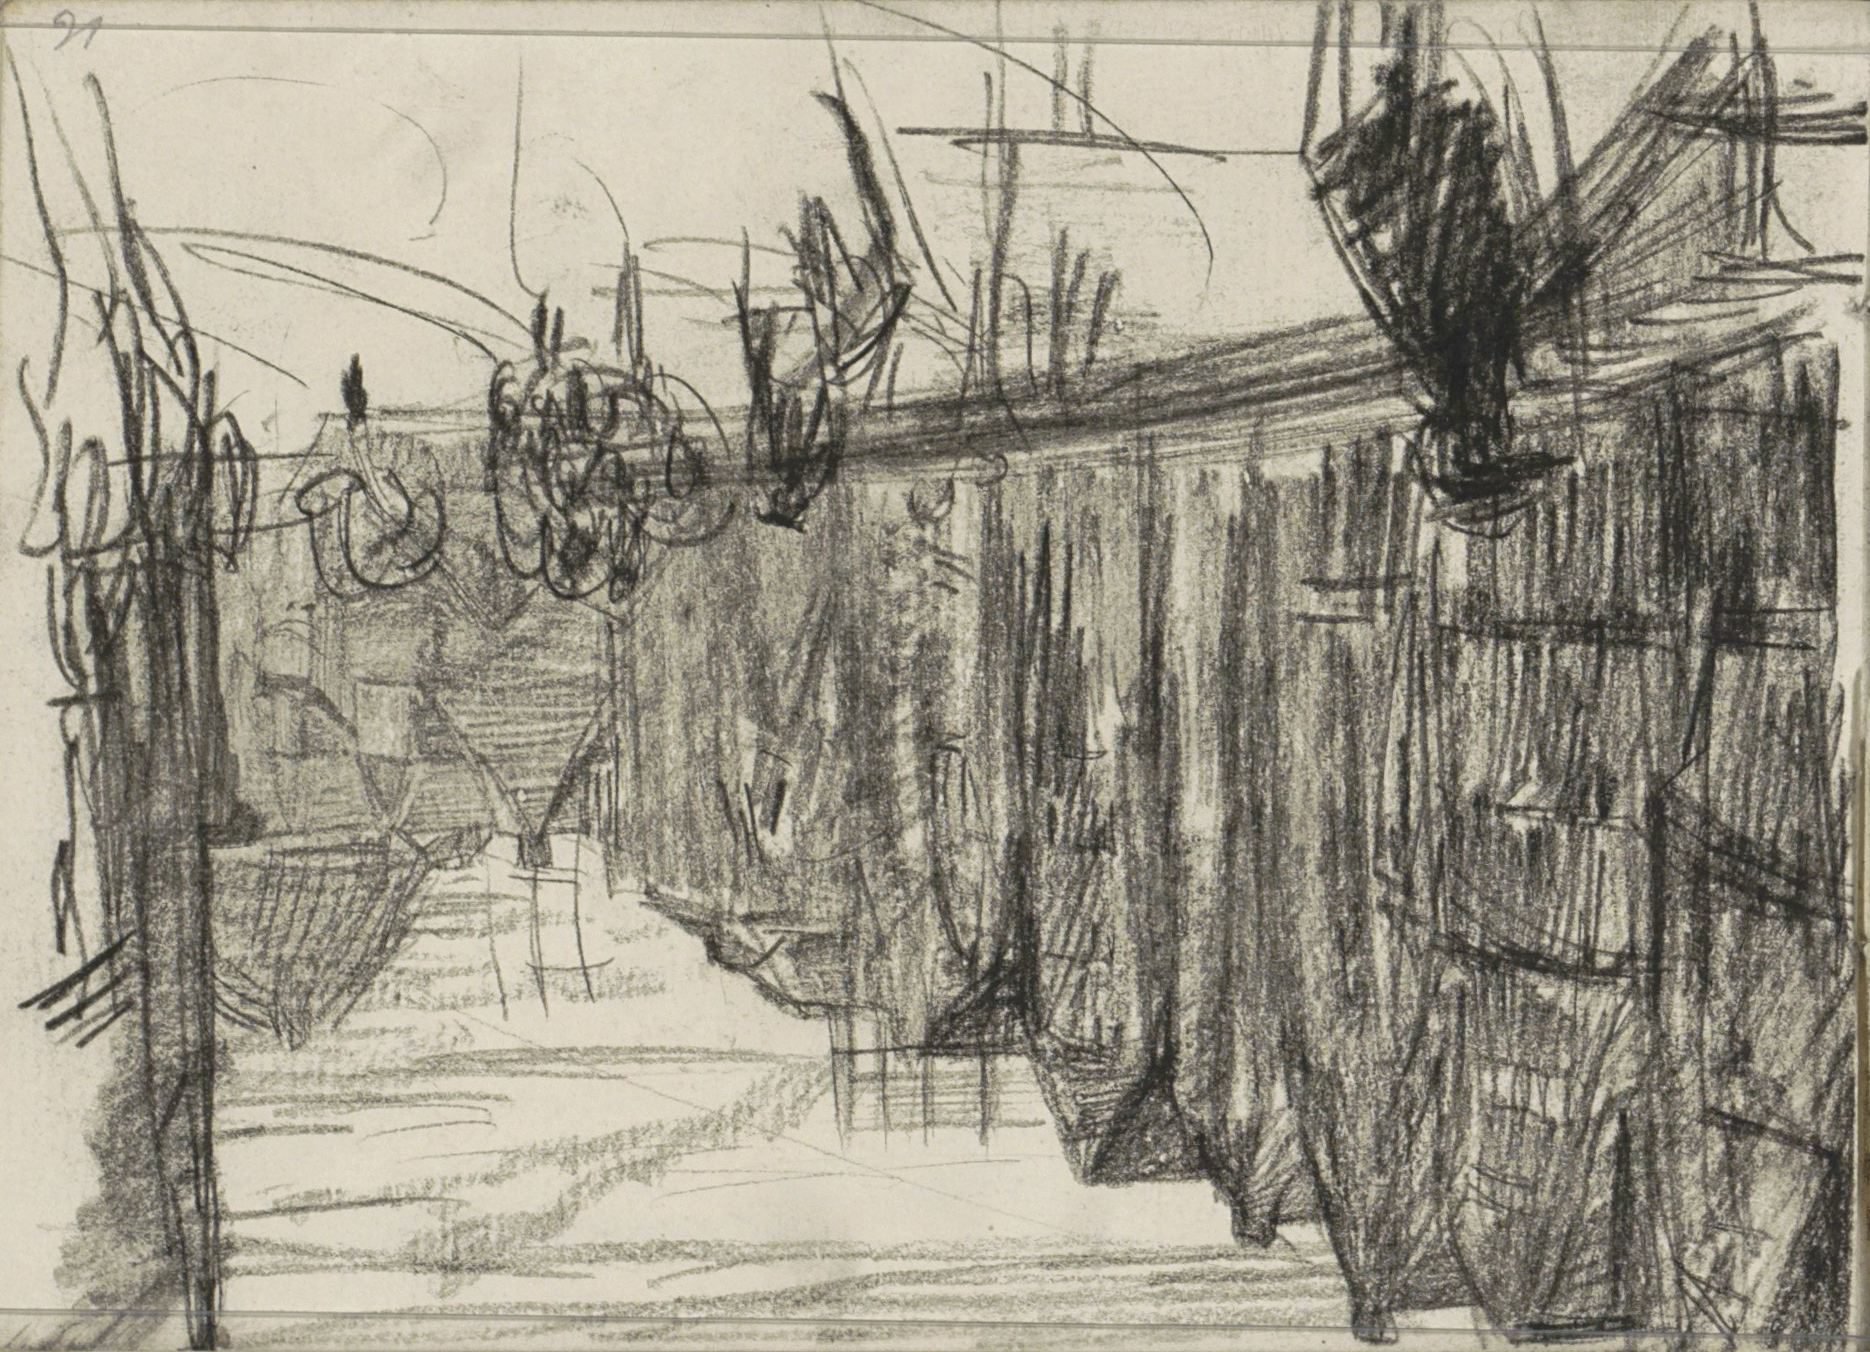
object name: sketchbook leaf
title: Stadsgezicht met figuren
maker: isaac israels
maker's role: draughtsman, painter, print maker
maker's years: 1865-1934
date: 1875-1934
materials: chalk, paper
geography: amsterdam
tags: city-view, and landscape with man-made constructions (+ city(-scape) with figures, staffage)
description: Blad 4 verso uit schetsboek XXXI met 10 bladen.